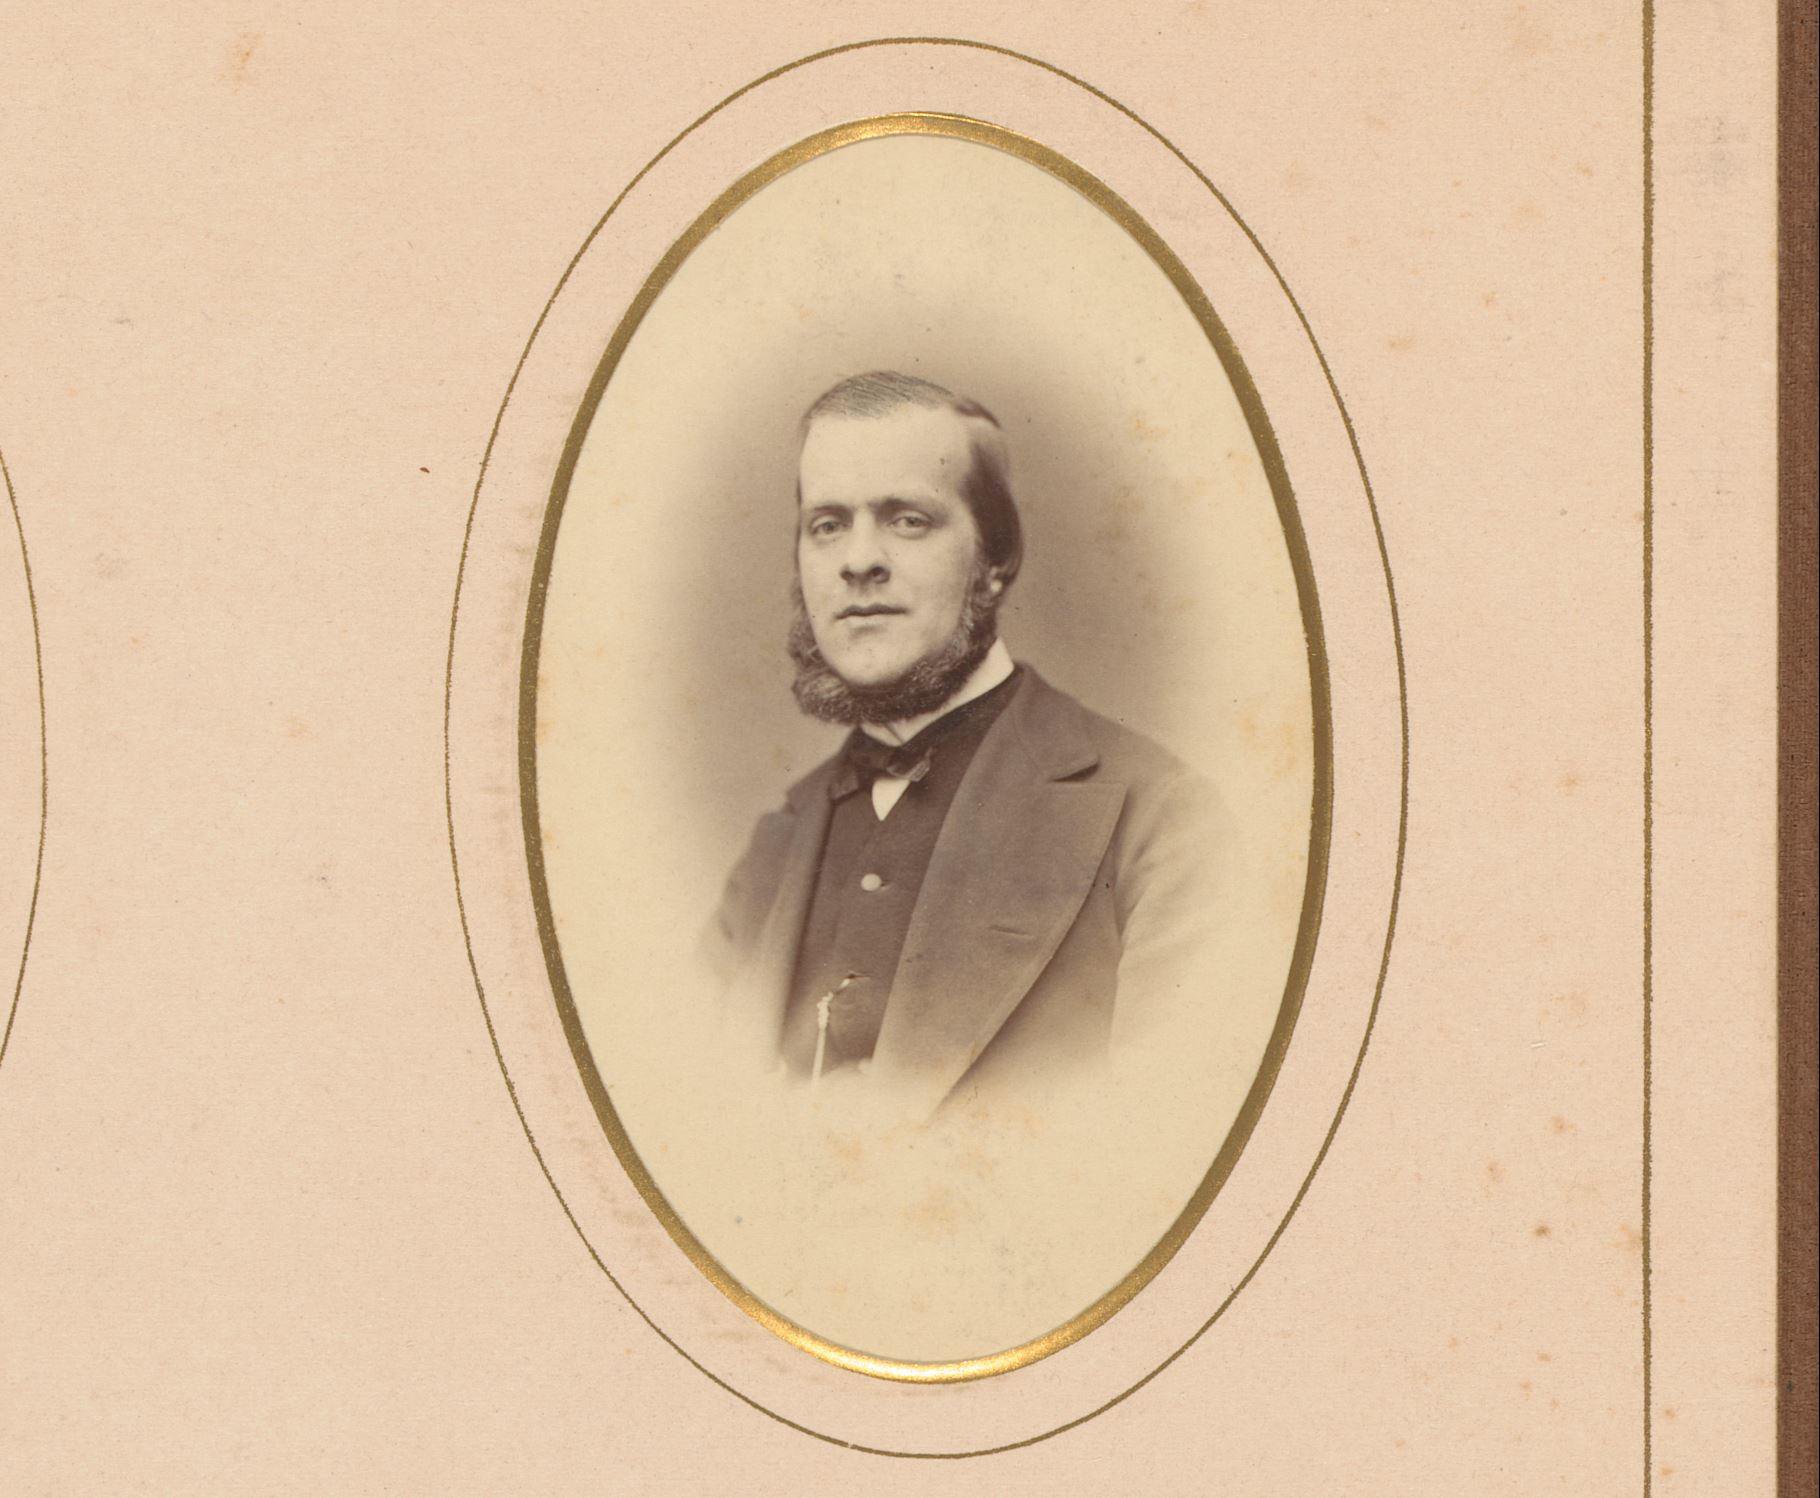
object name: album leaf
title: Portret van een man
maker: albert greiner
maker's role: fotograaf, fotostudio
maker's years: 1833-1890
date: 1861-1890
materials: cardboard, photographic support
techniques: albumen print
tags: historical persons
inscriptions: inscription: ‘A. Greiner/ Photograf/ NIEUWENDIJK L. 87/ AMSTERDAM.’